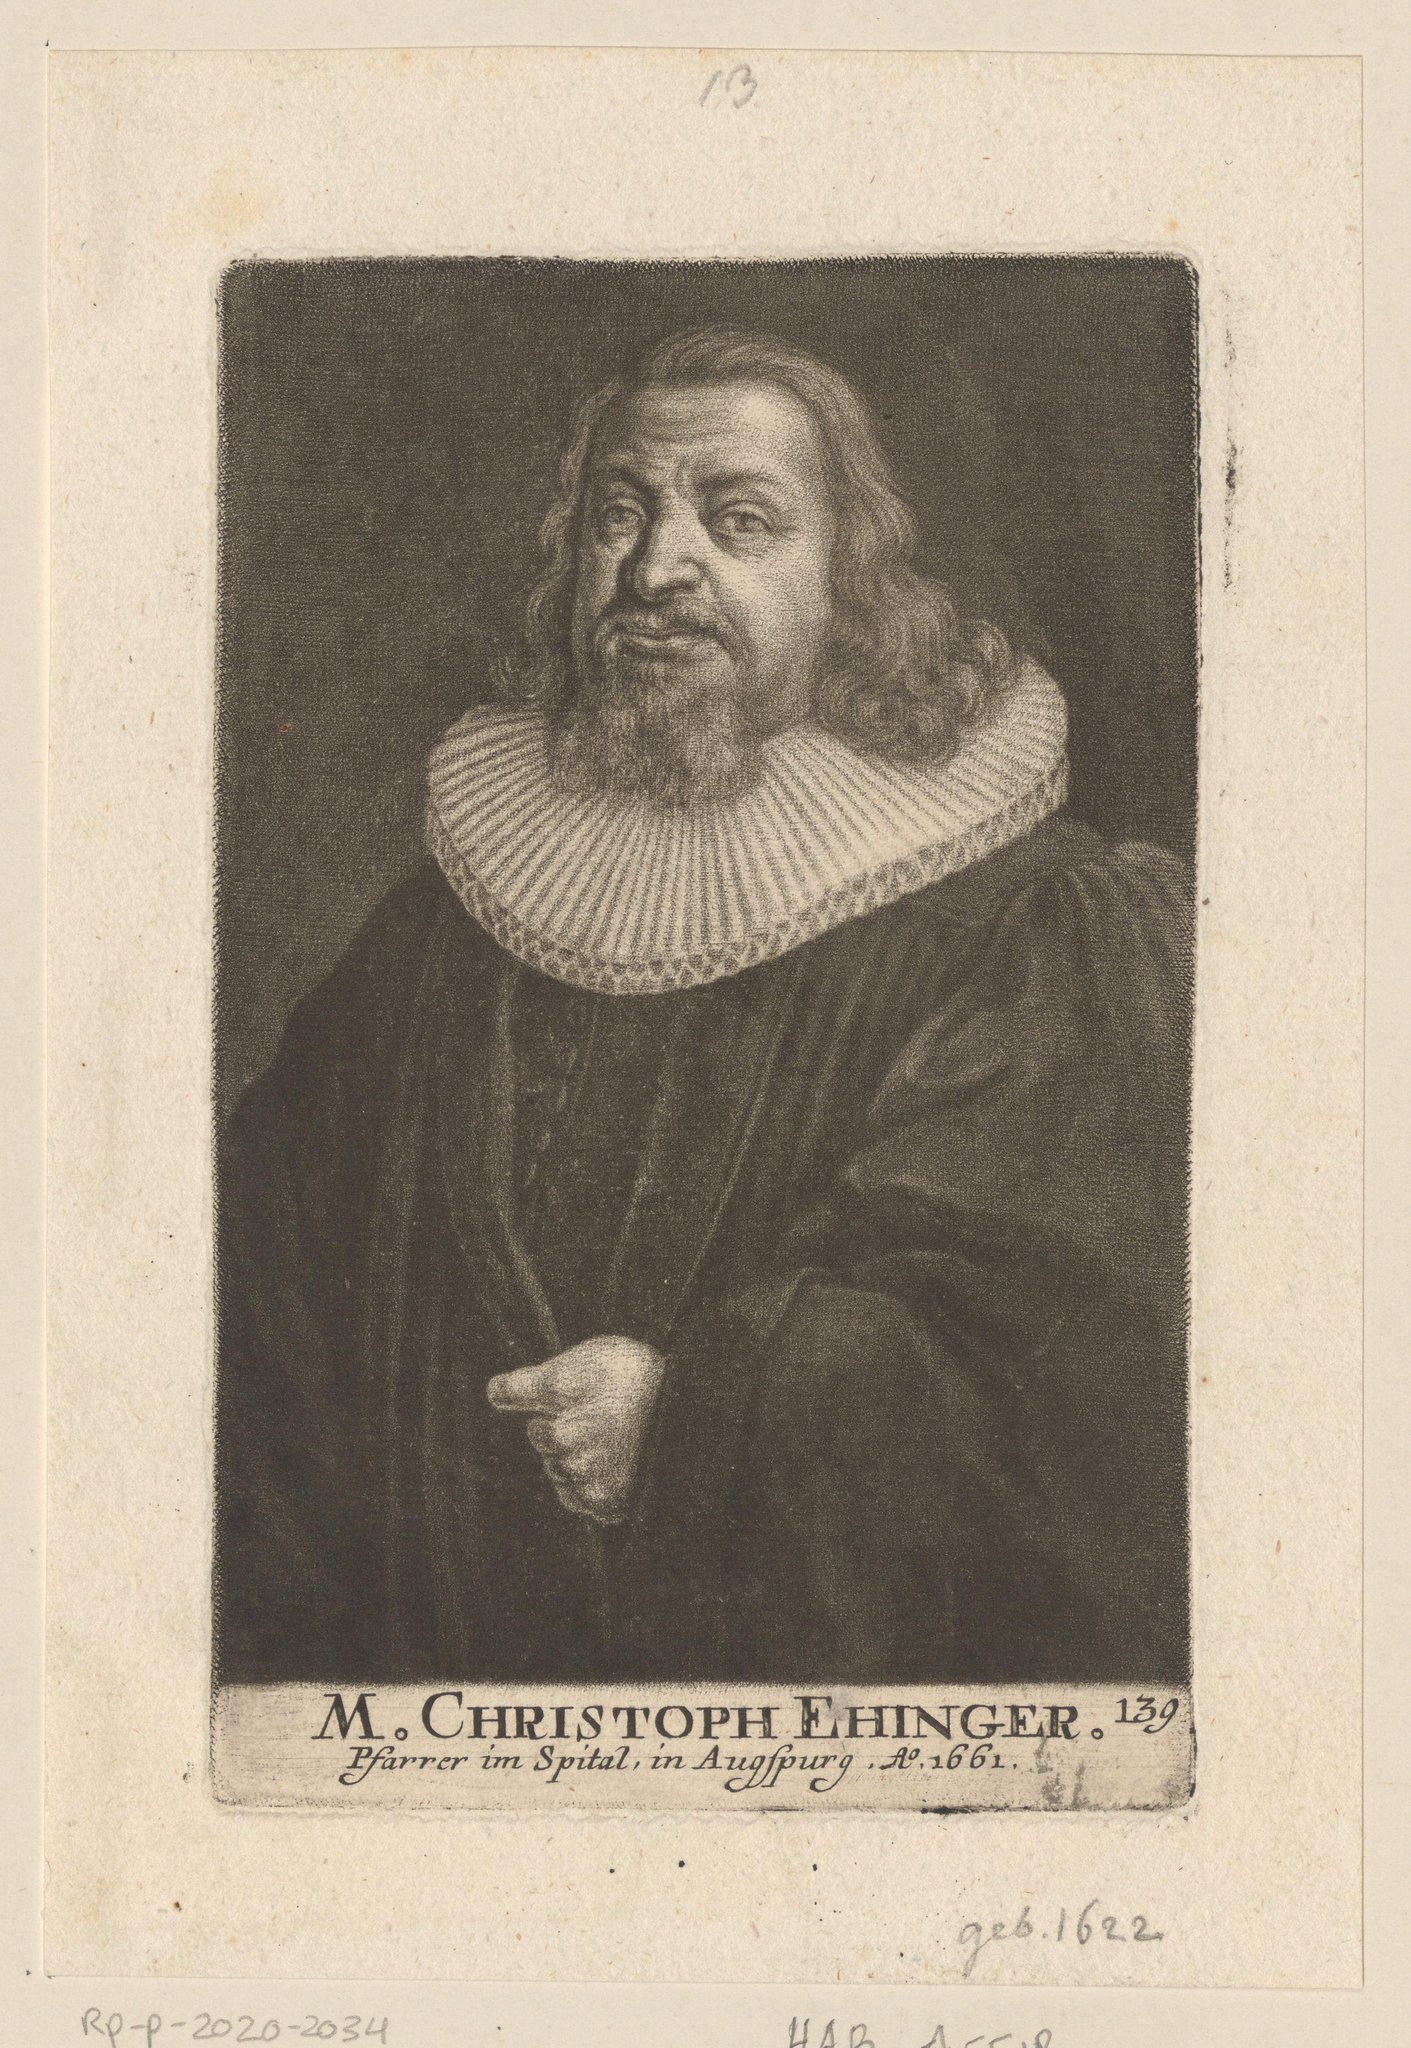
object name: book illustration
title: Portret van Christoph Ehinger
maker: Anonymous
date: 1749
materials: paper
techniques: mezzotint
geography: germany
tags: augsburg, theologian, historical persons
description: Prent waarschijnlijk uit: Rein, Joseph Friedrich. Das gesamte Augspurgische Evangelische Ministerium in Bildern und Schrifften: von den erstern Jahren der Reformation Lutheri, bis auf Anno 1748. oder das Jubel-Jahr wegen des Westphälischen Friedens. Augsburg: weduwe Samuel Fincke, [1749], dl. 2.